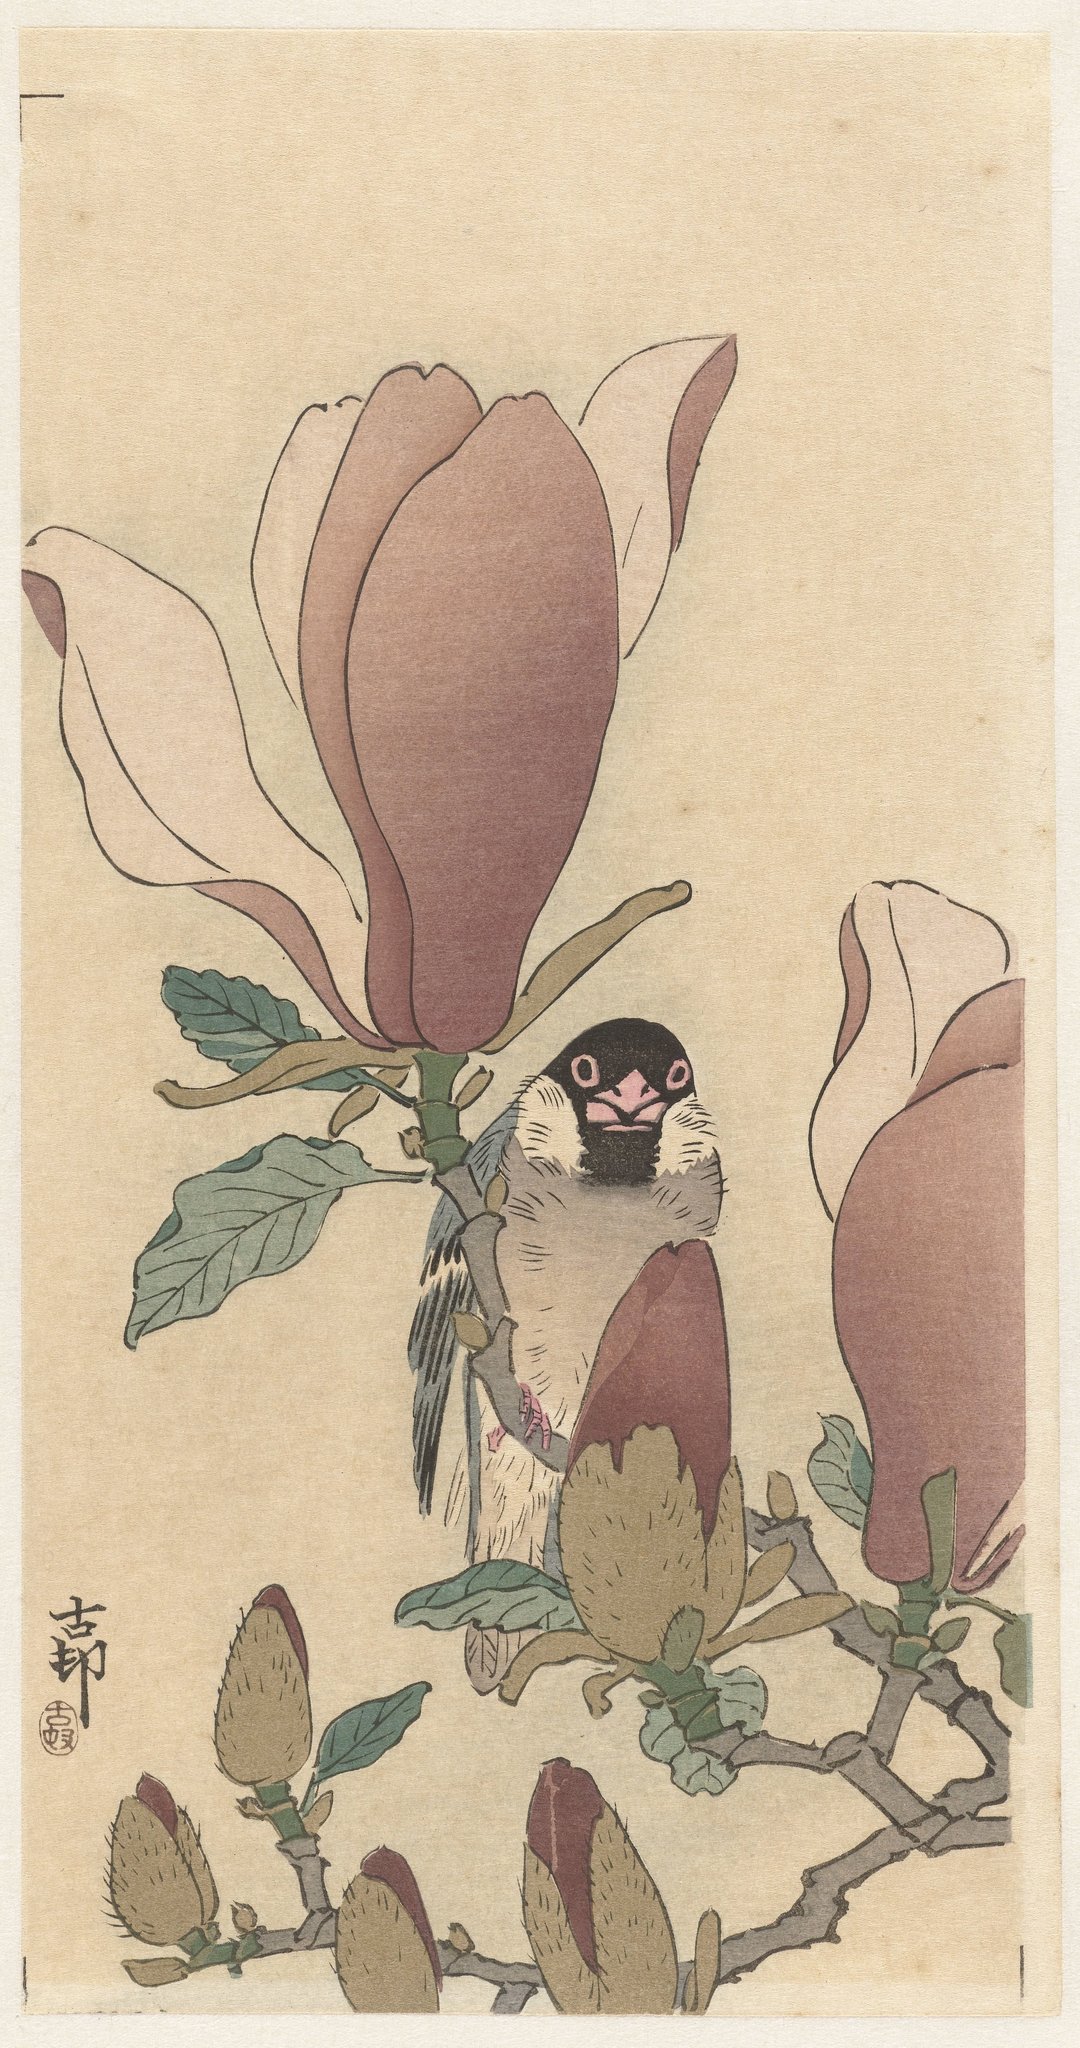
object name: print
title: Mus op bloeiende magnolia tak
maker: ohara koson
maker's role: print maker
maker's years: 1877-1945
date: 1900-1930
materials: paper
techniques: woodcut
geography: japan